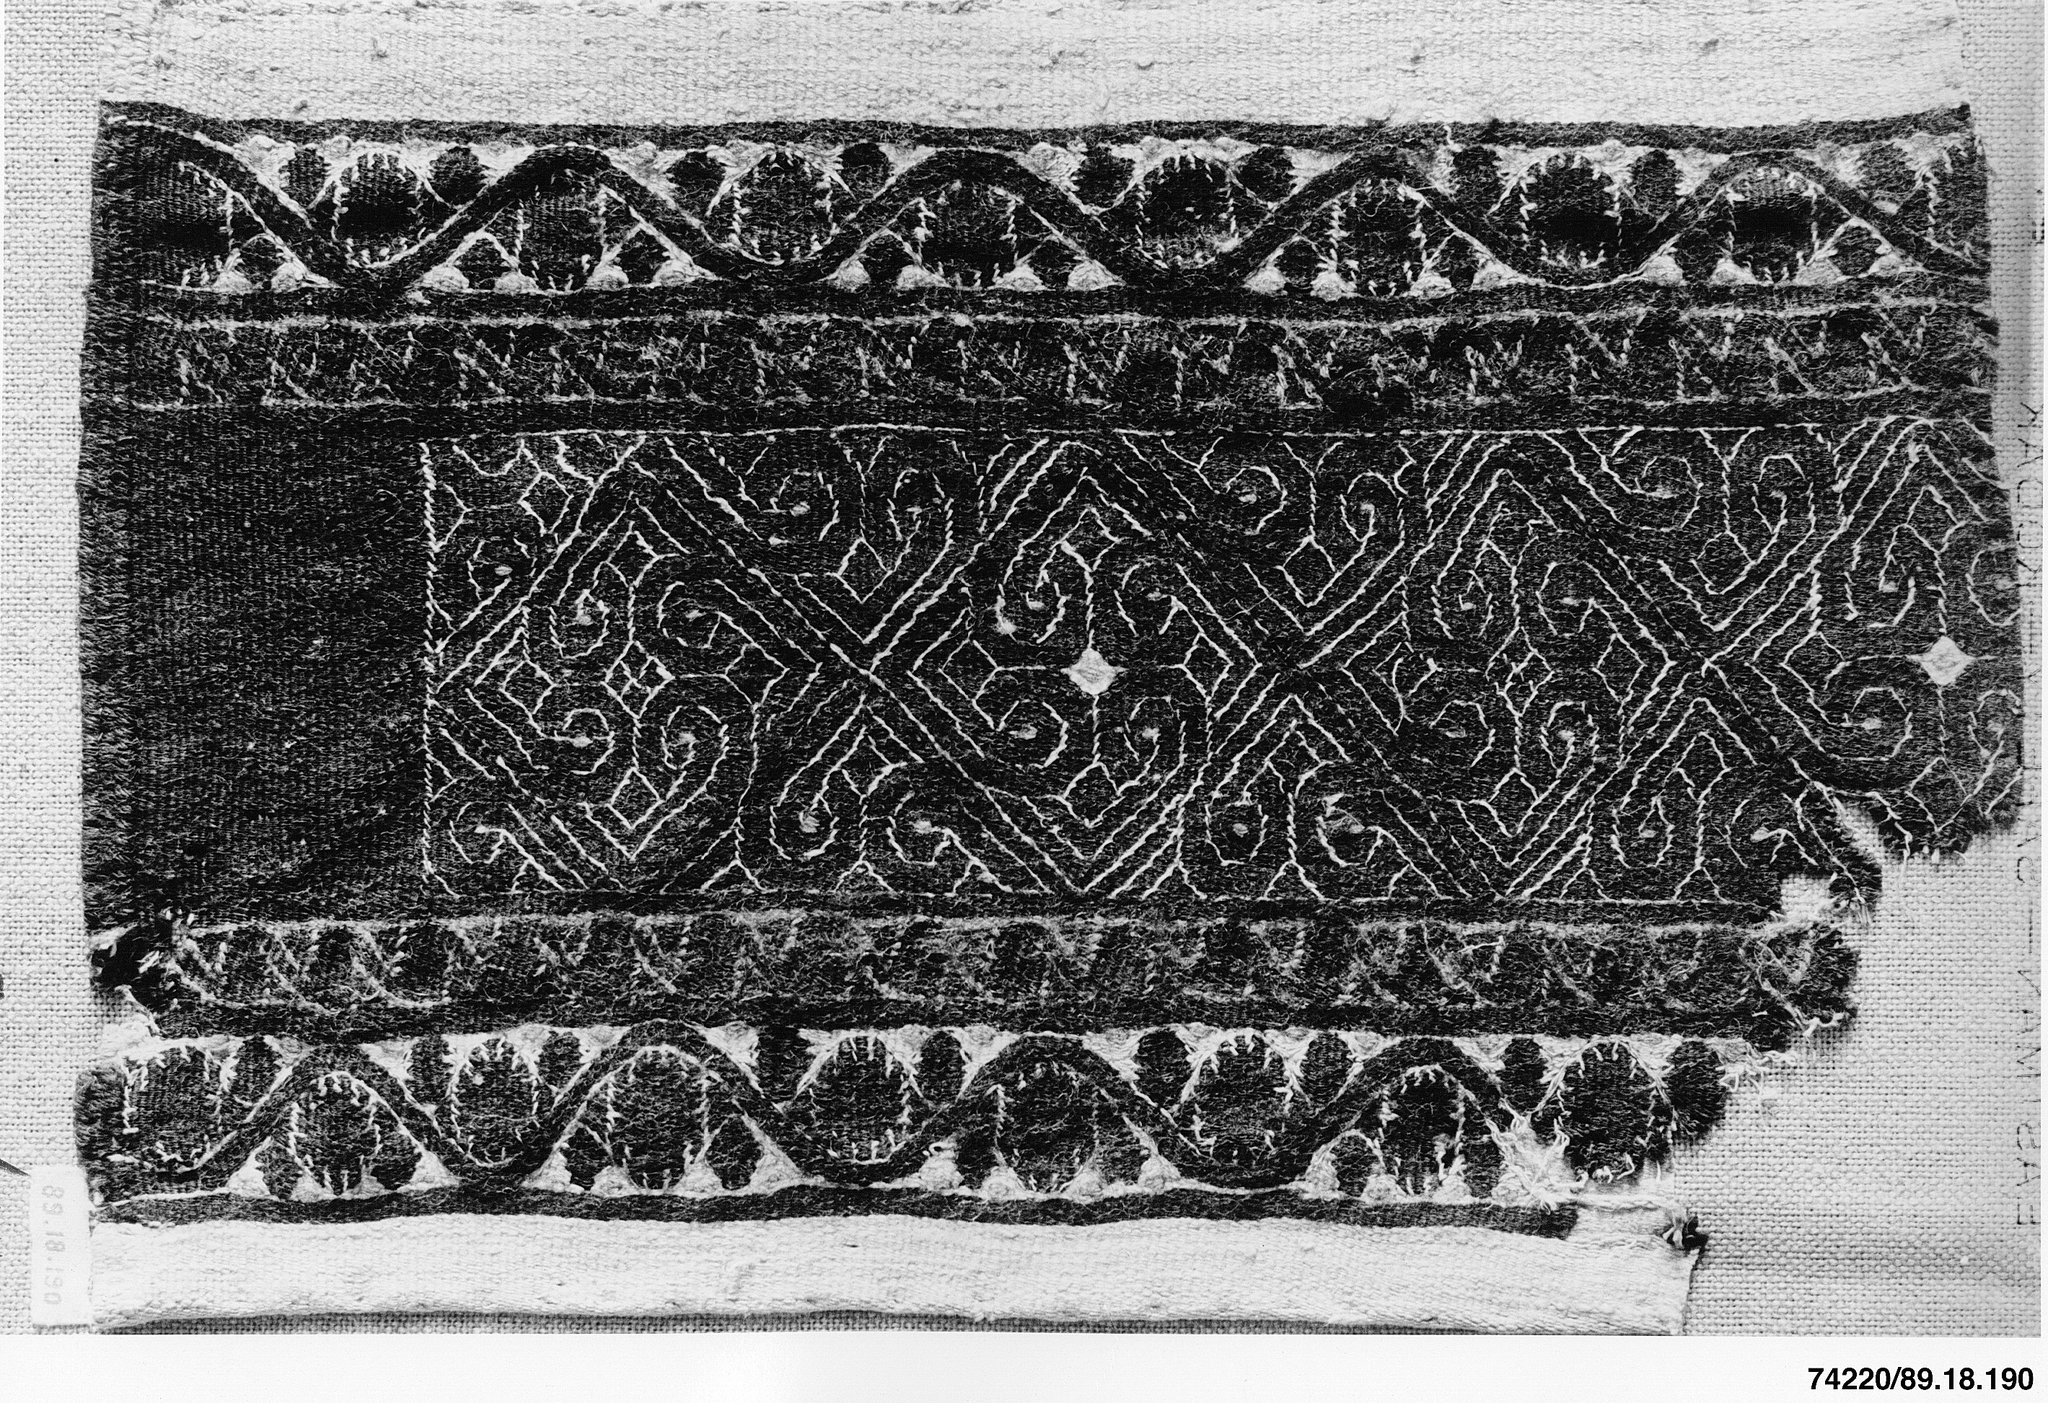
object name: textile fragment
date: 201-400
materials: linen, wool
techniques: weave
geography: egypt